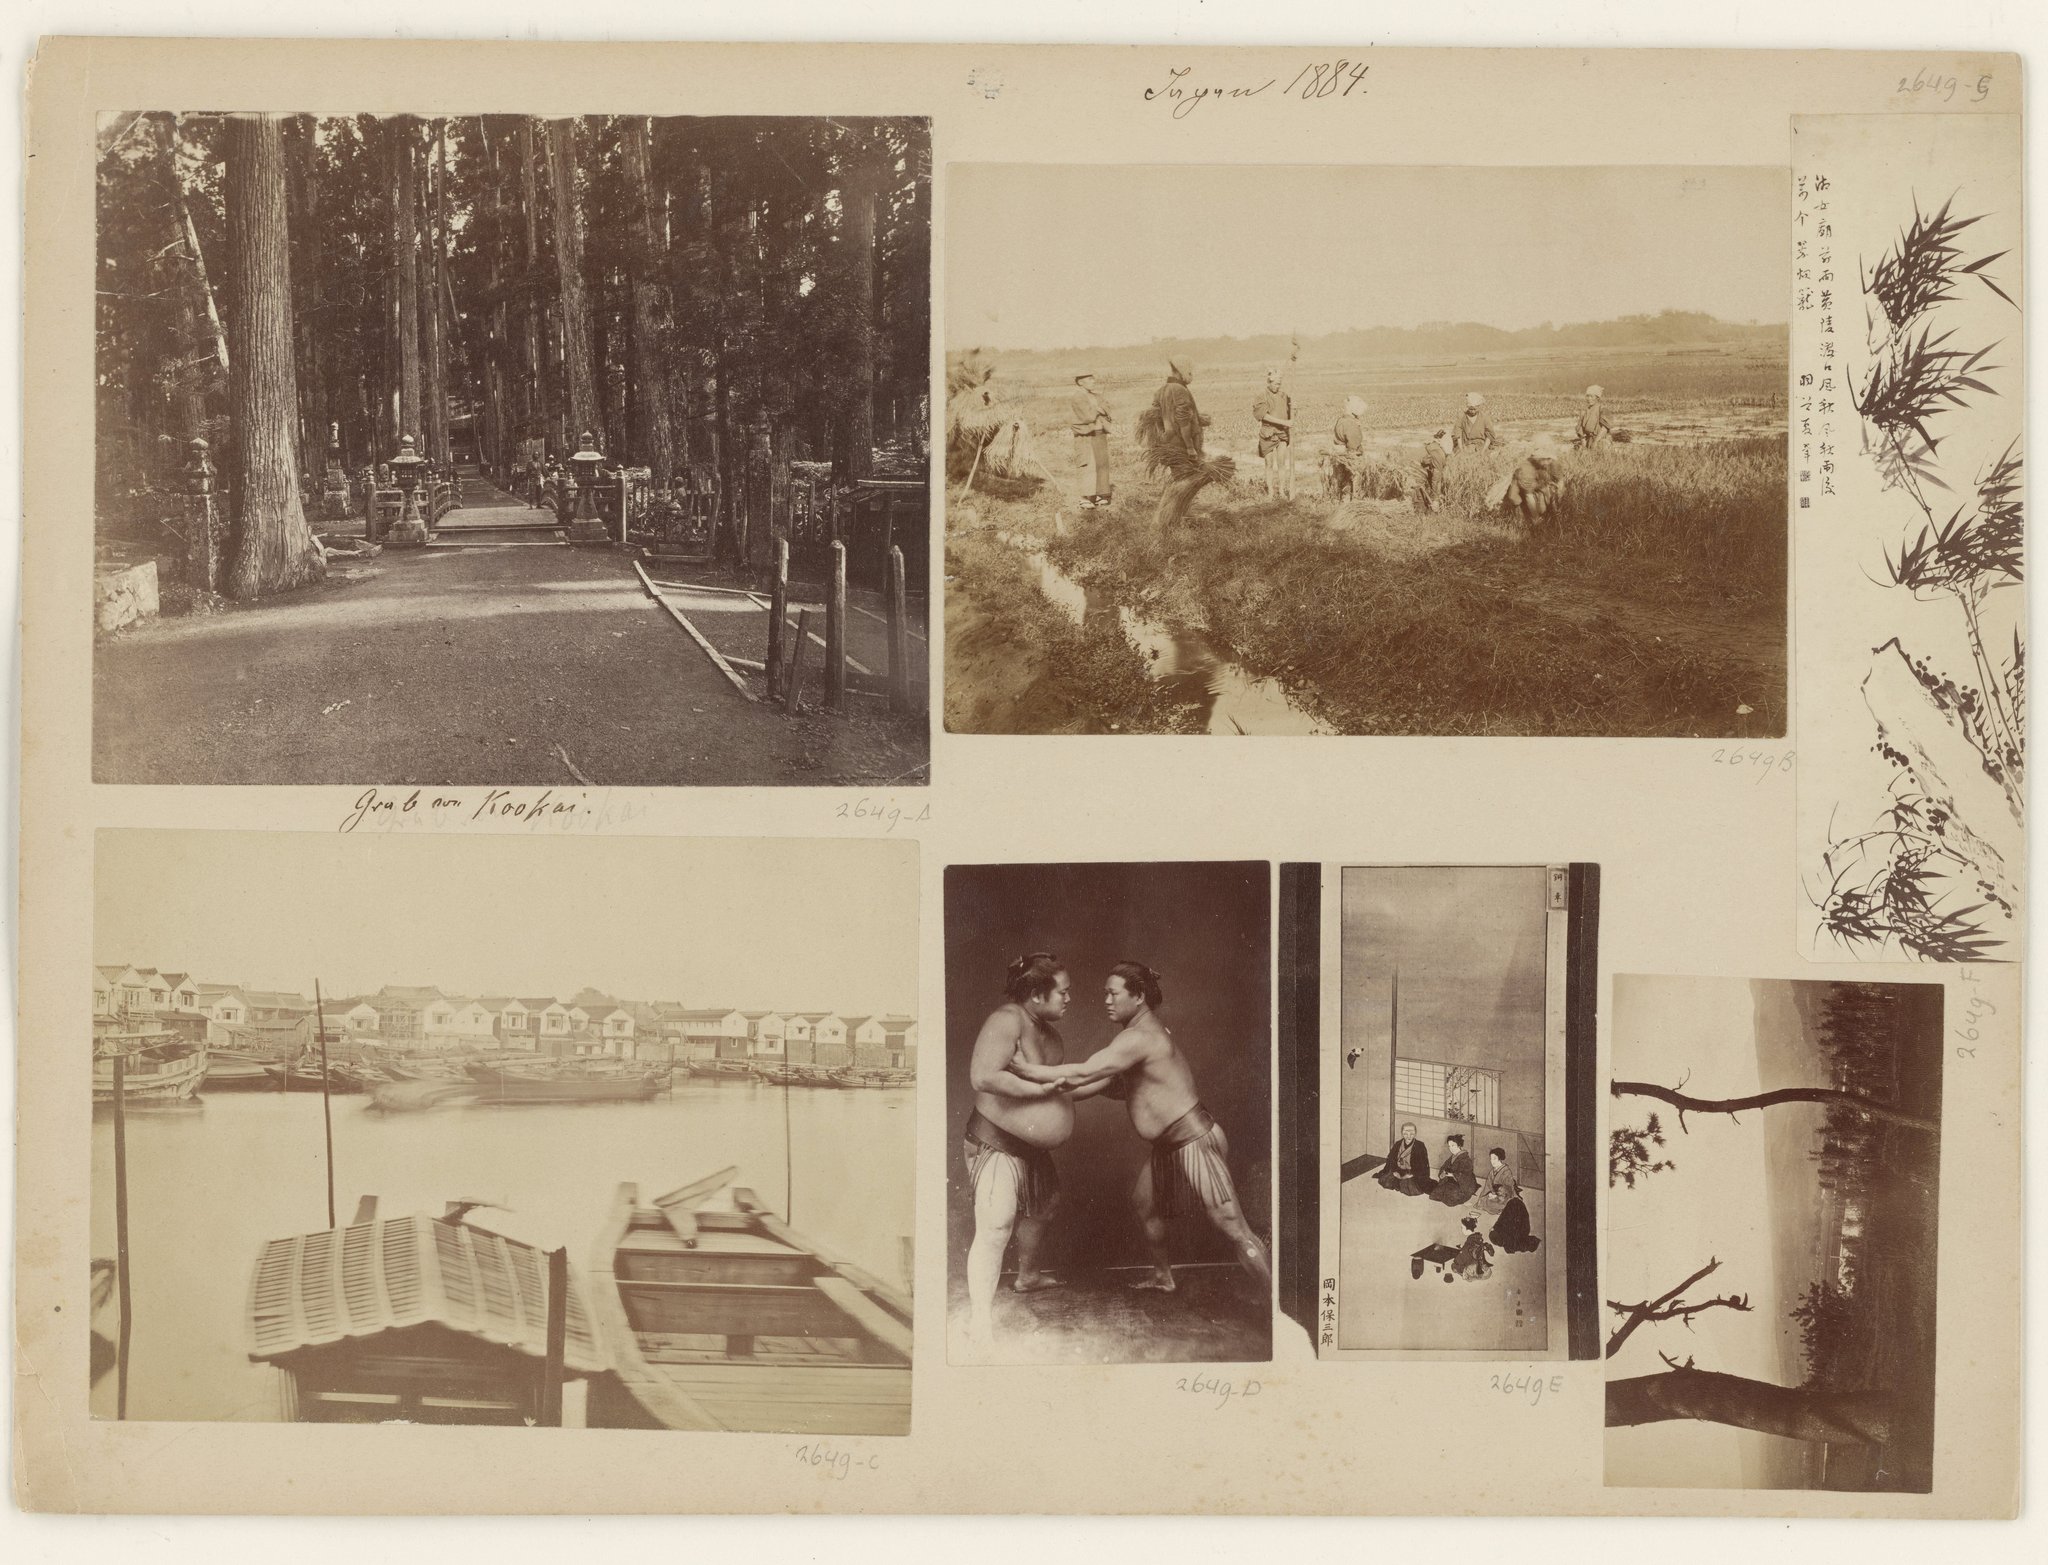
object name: photograph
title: Japan 1884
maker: Anonymous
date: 1884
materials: cardboard, paper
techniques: albumen print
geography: japan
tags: (high) hill, japan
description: Onderdeel van een blad met zeven foto's.